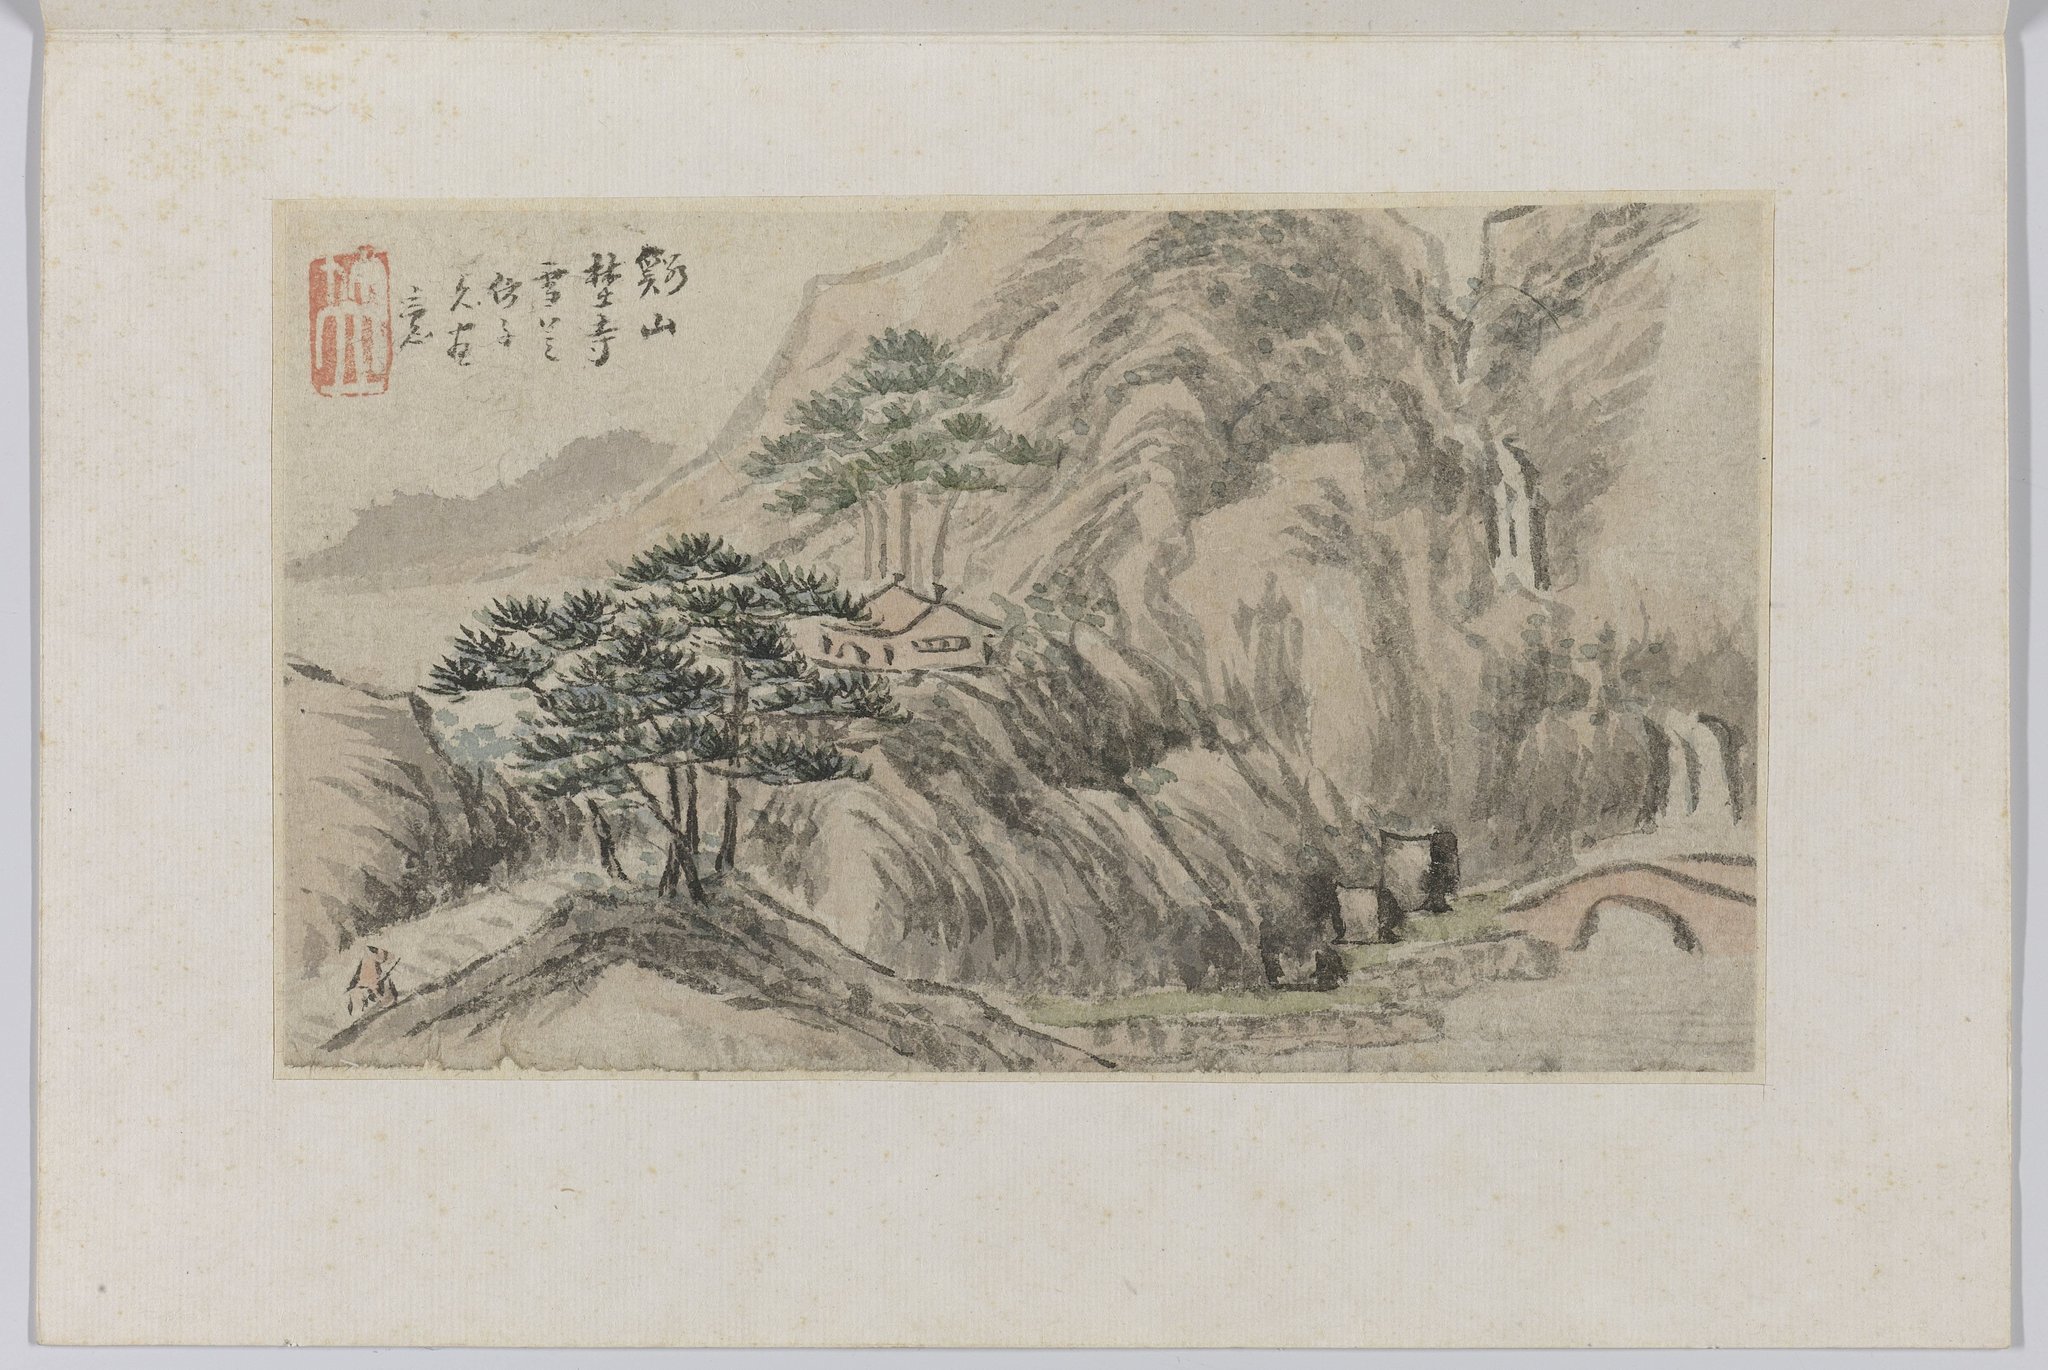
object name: painting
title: Landschap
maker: cheng men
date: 1850-1900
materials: ink, paper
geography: shexian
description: Albumblad met een landschap. Gesigneerd door Cheng Men, bekend als porseleinschilder in Jingdezhen.